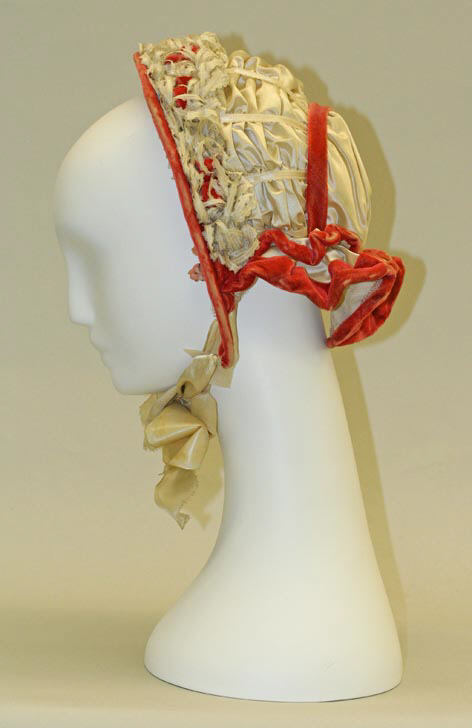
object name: promenade bonnet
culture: american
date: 1851-1862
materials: cotton, silk, metal